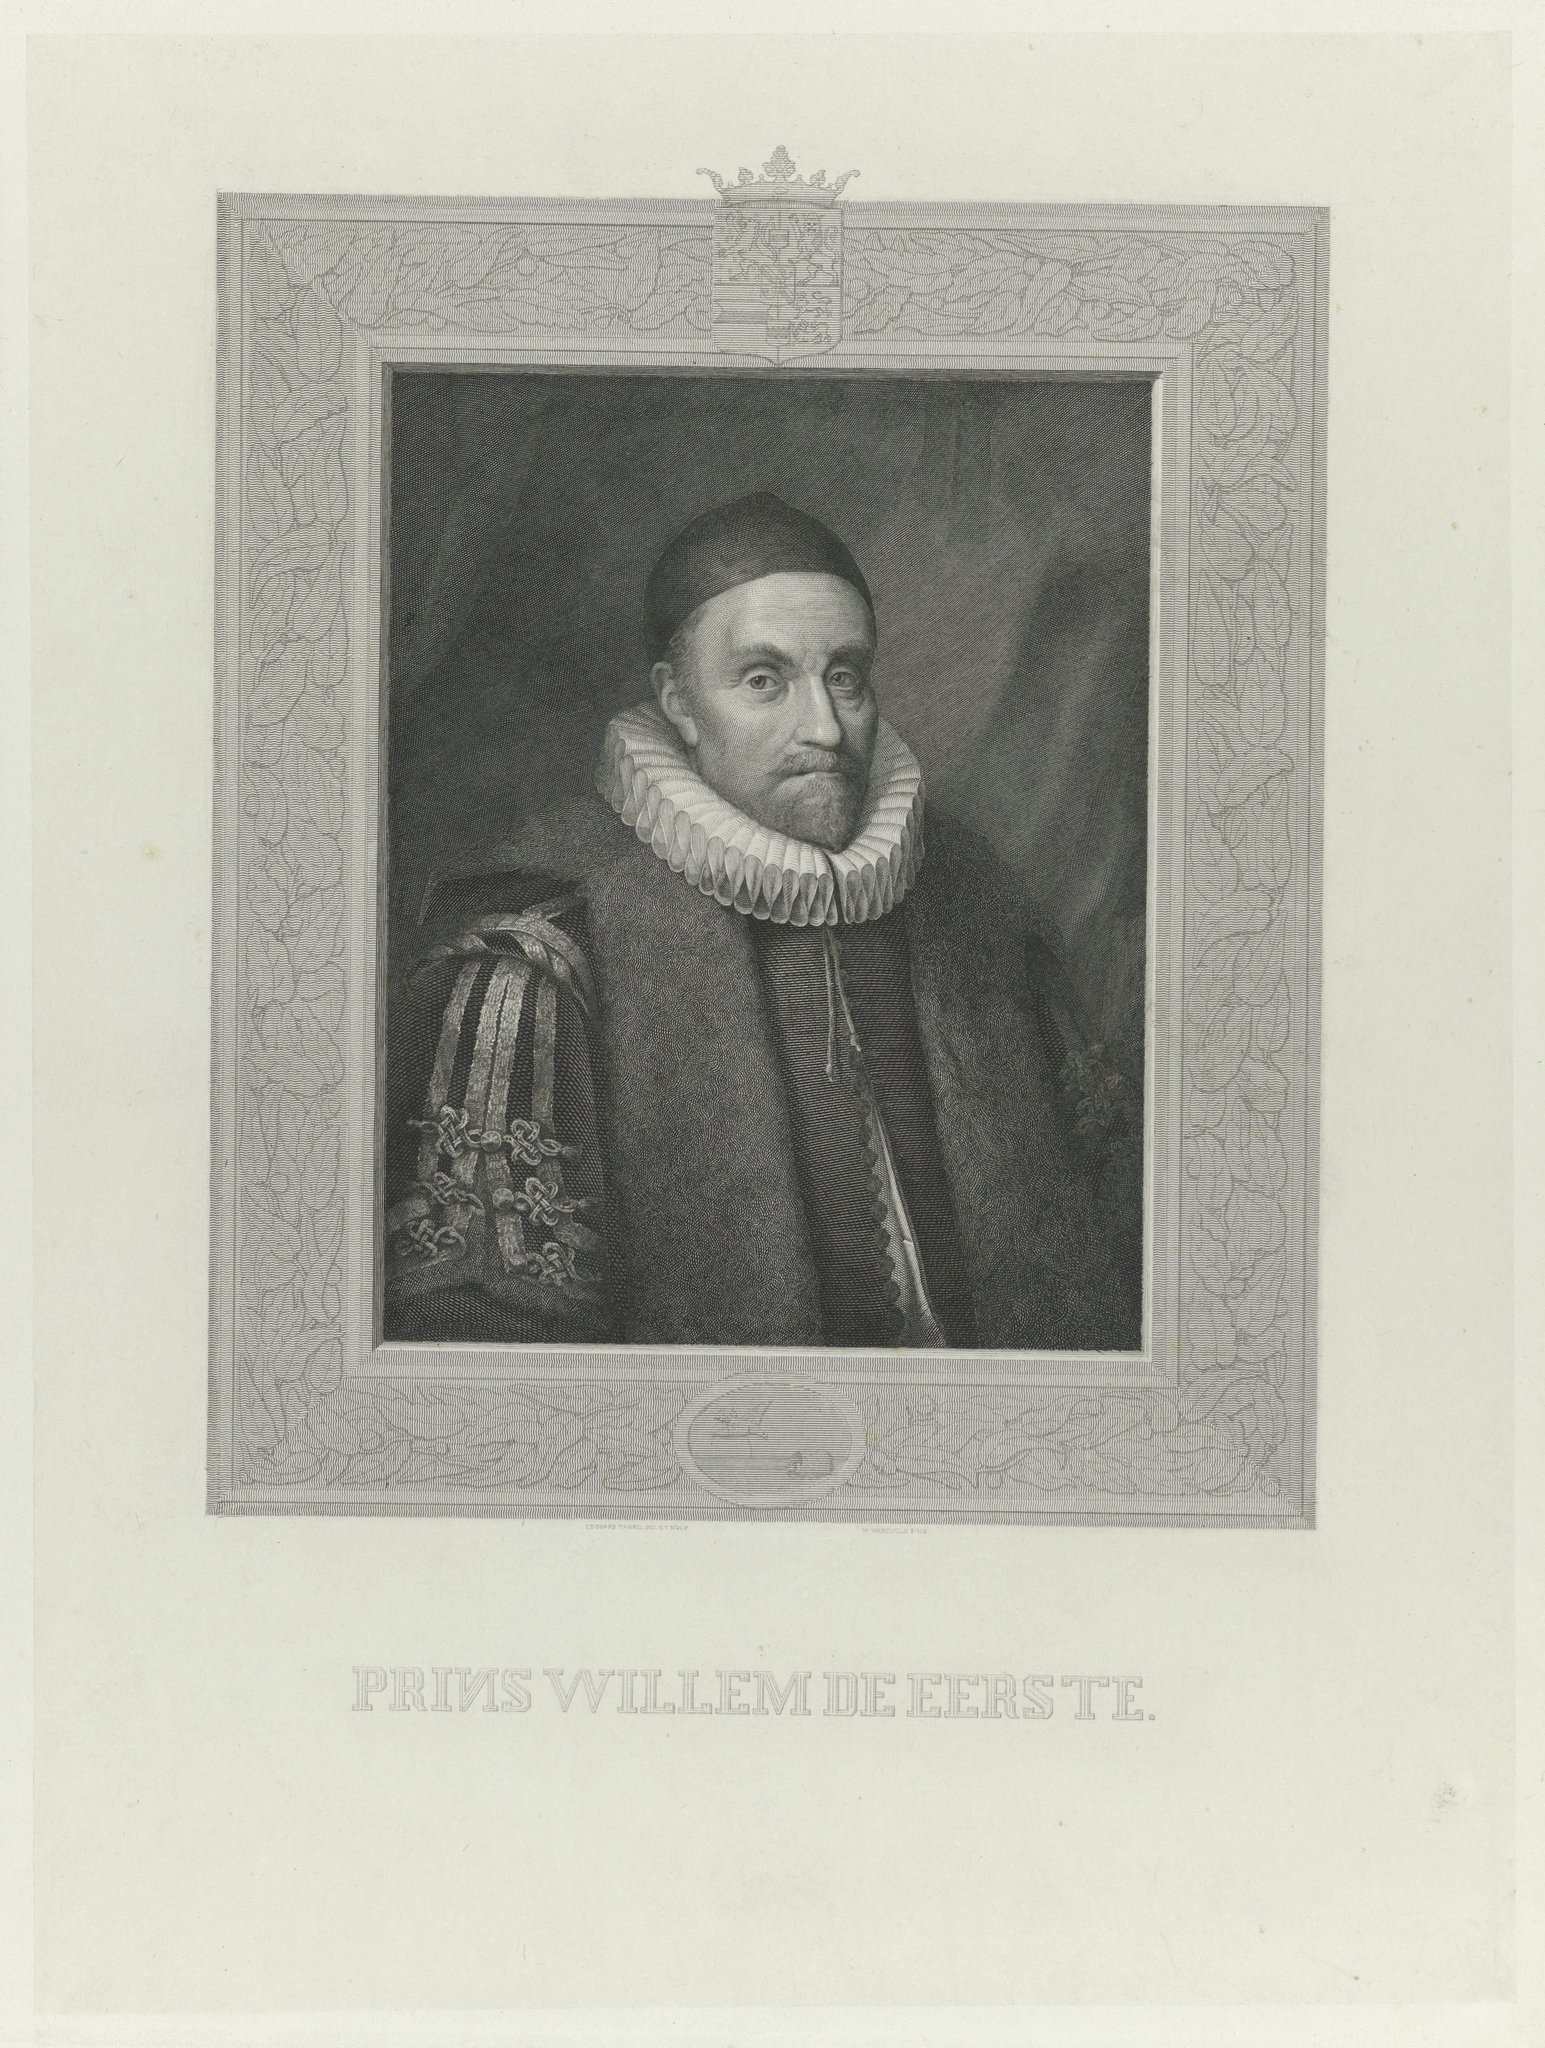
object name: print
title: Portret van Willem I, prins van Oranje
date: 1839-1871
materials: paper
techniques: engraving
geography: amsterdam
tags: delft, william i (prince of orange)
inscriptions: collector's mark: Lugt 963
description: De hier vermelde titel verwijst naar de hoogst verkregen titel van de geportretteerde, niet per se naar de titel die de geportretteerde op deze voorstelling draagt.